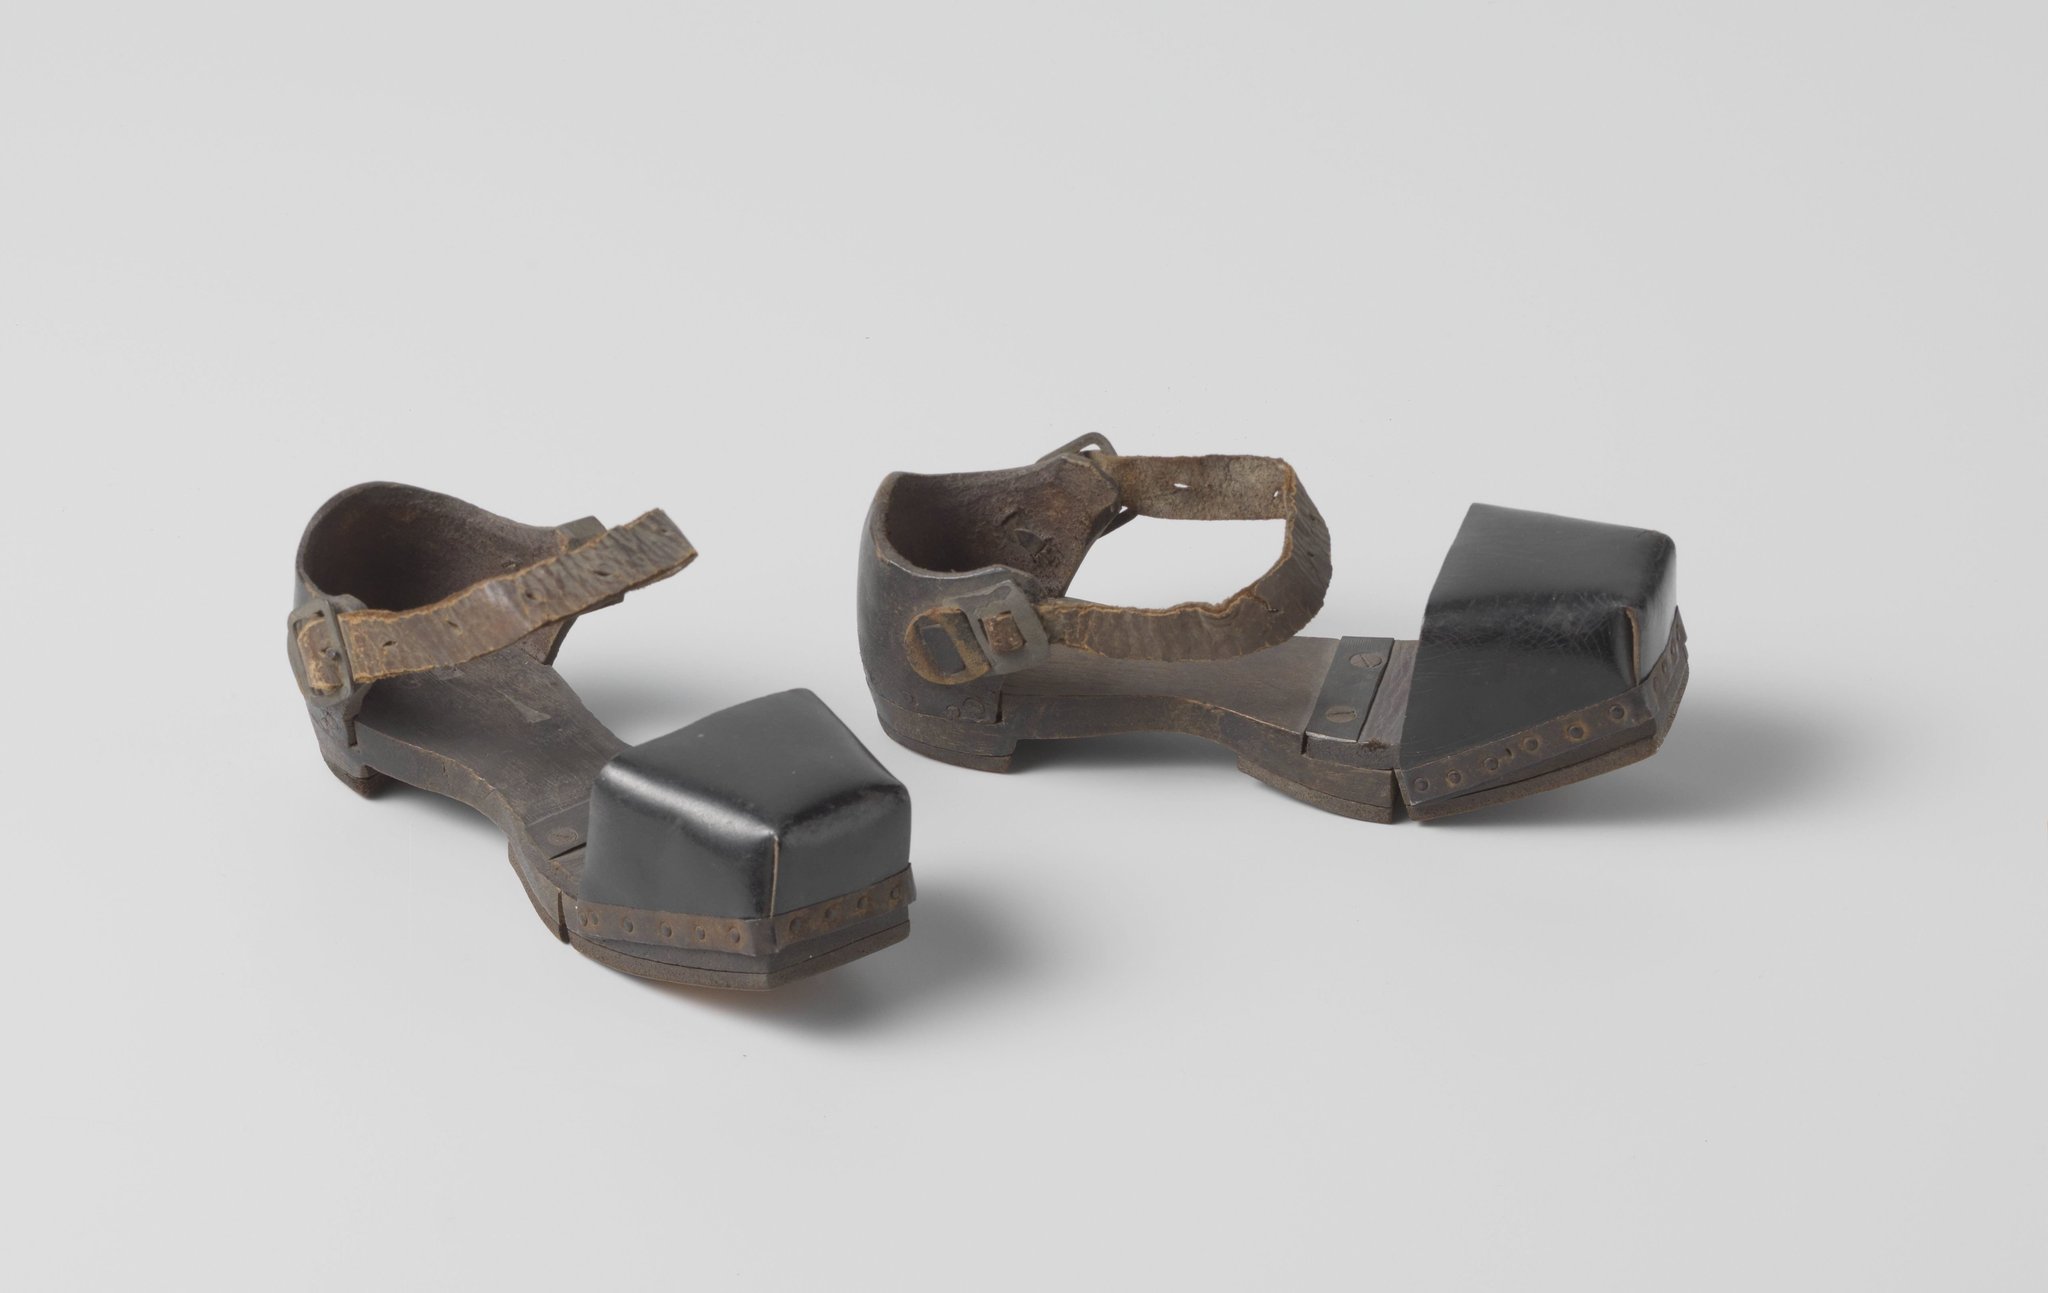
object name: mule shoe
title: Schoen of muil, met houten zolen die in de buiging van de voet scharnieren, voorzool en hak met leer bekleed, hielband en gespen van koper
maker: Anonymous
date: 1800-1900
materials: copper, leather, wood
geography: netherlands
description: Schoen of muil met houten zolen die in de buiging van de voet scharniert. Voorzool en hak met leer bekleed, vierkante neus. Hielband en gespen van koper. Gemerkt: 72. Kindermodel